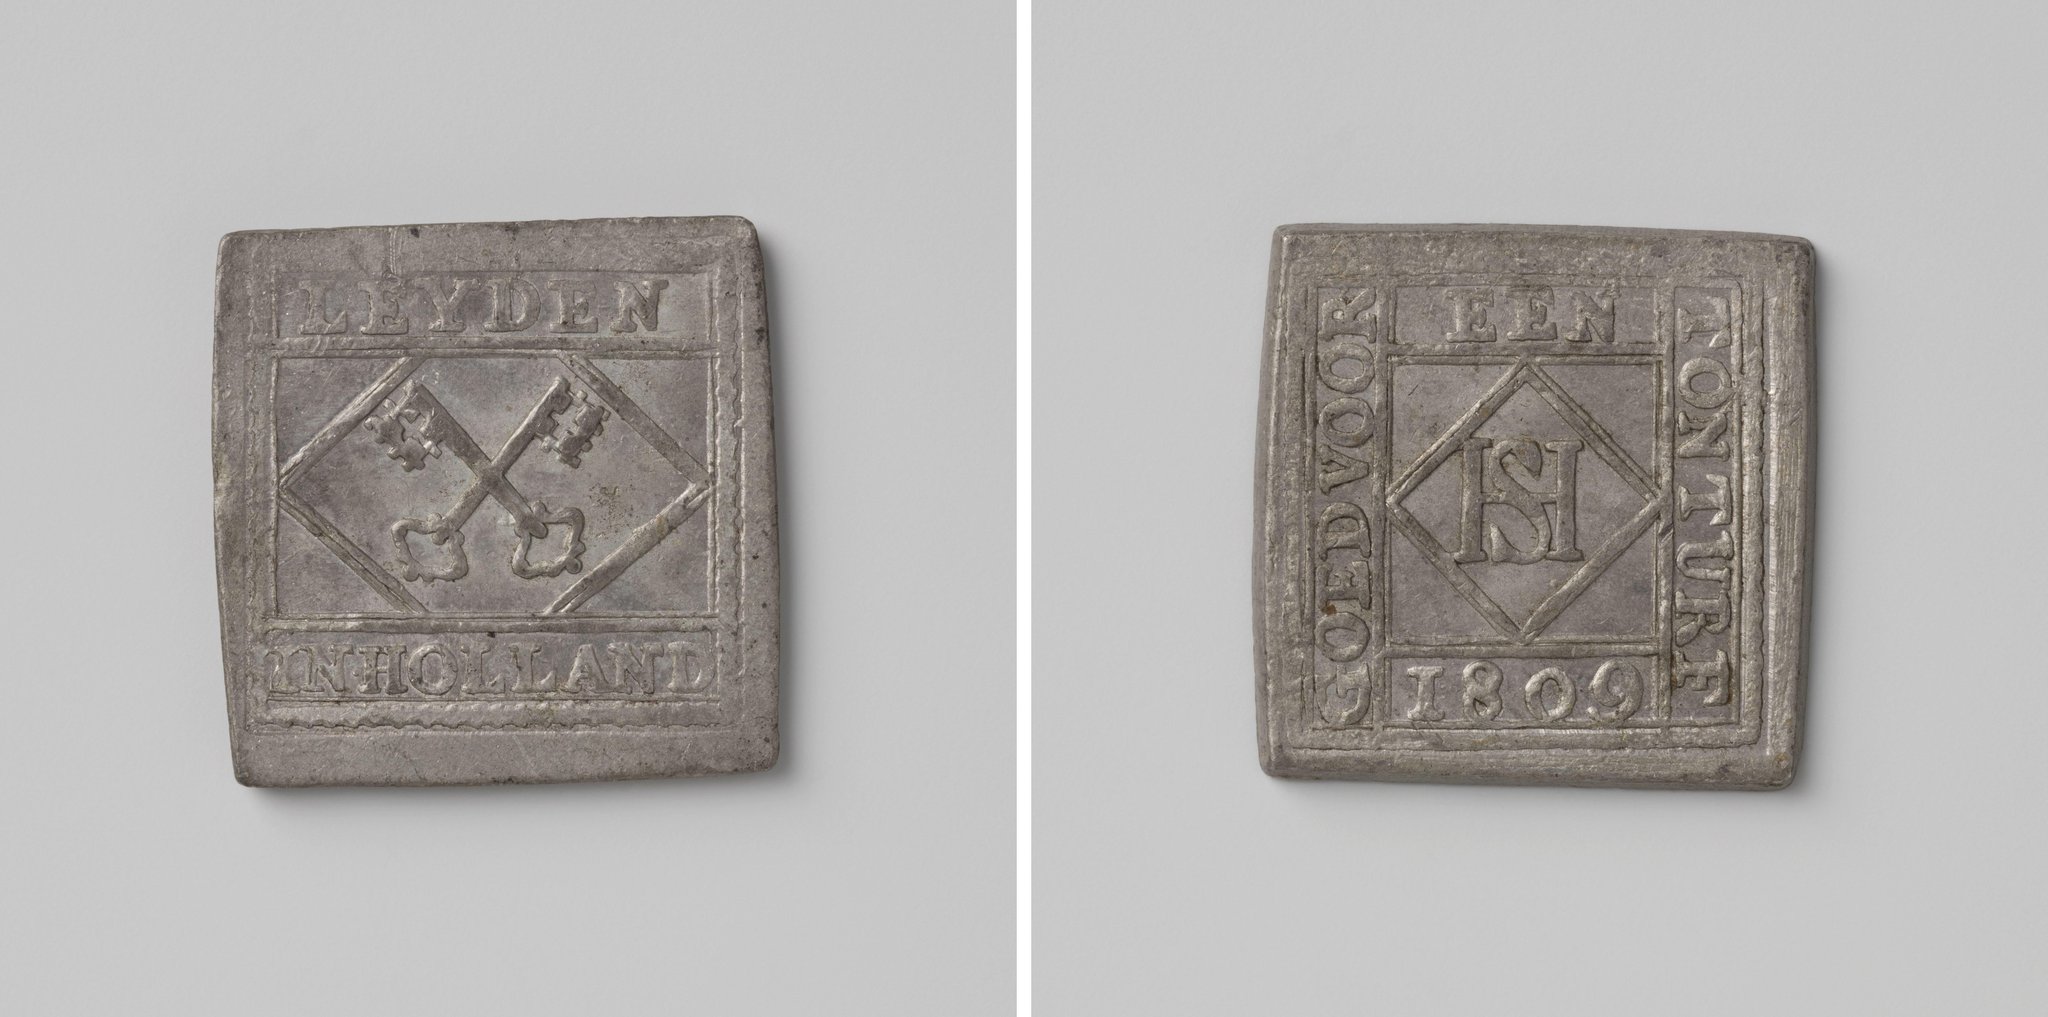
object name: loden penning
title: Huiszittenhuis te Leiden, armenpenning die bij uitdeling recht gaf op een ton turf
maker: Anonymous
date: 1809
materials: lead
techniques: striking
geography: leiden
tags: leiden